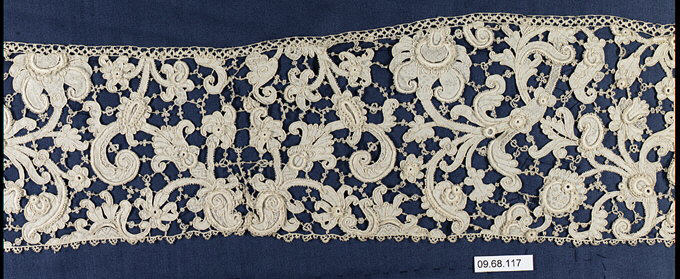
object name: piece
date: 1601-1700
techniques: lace